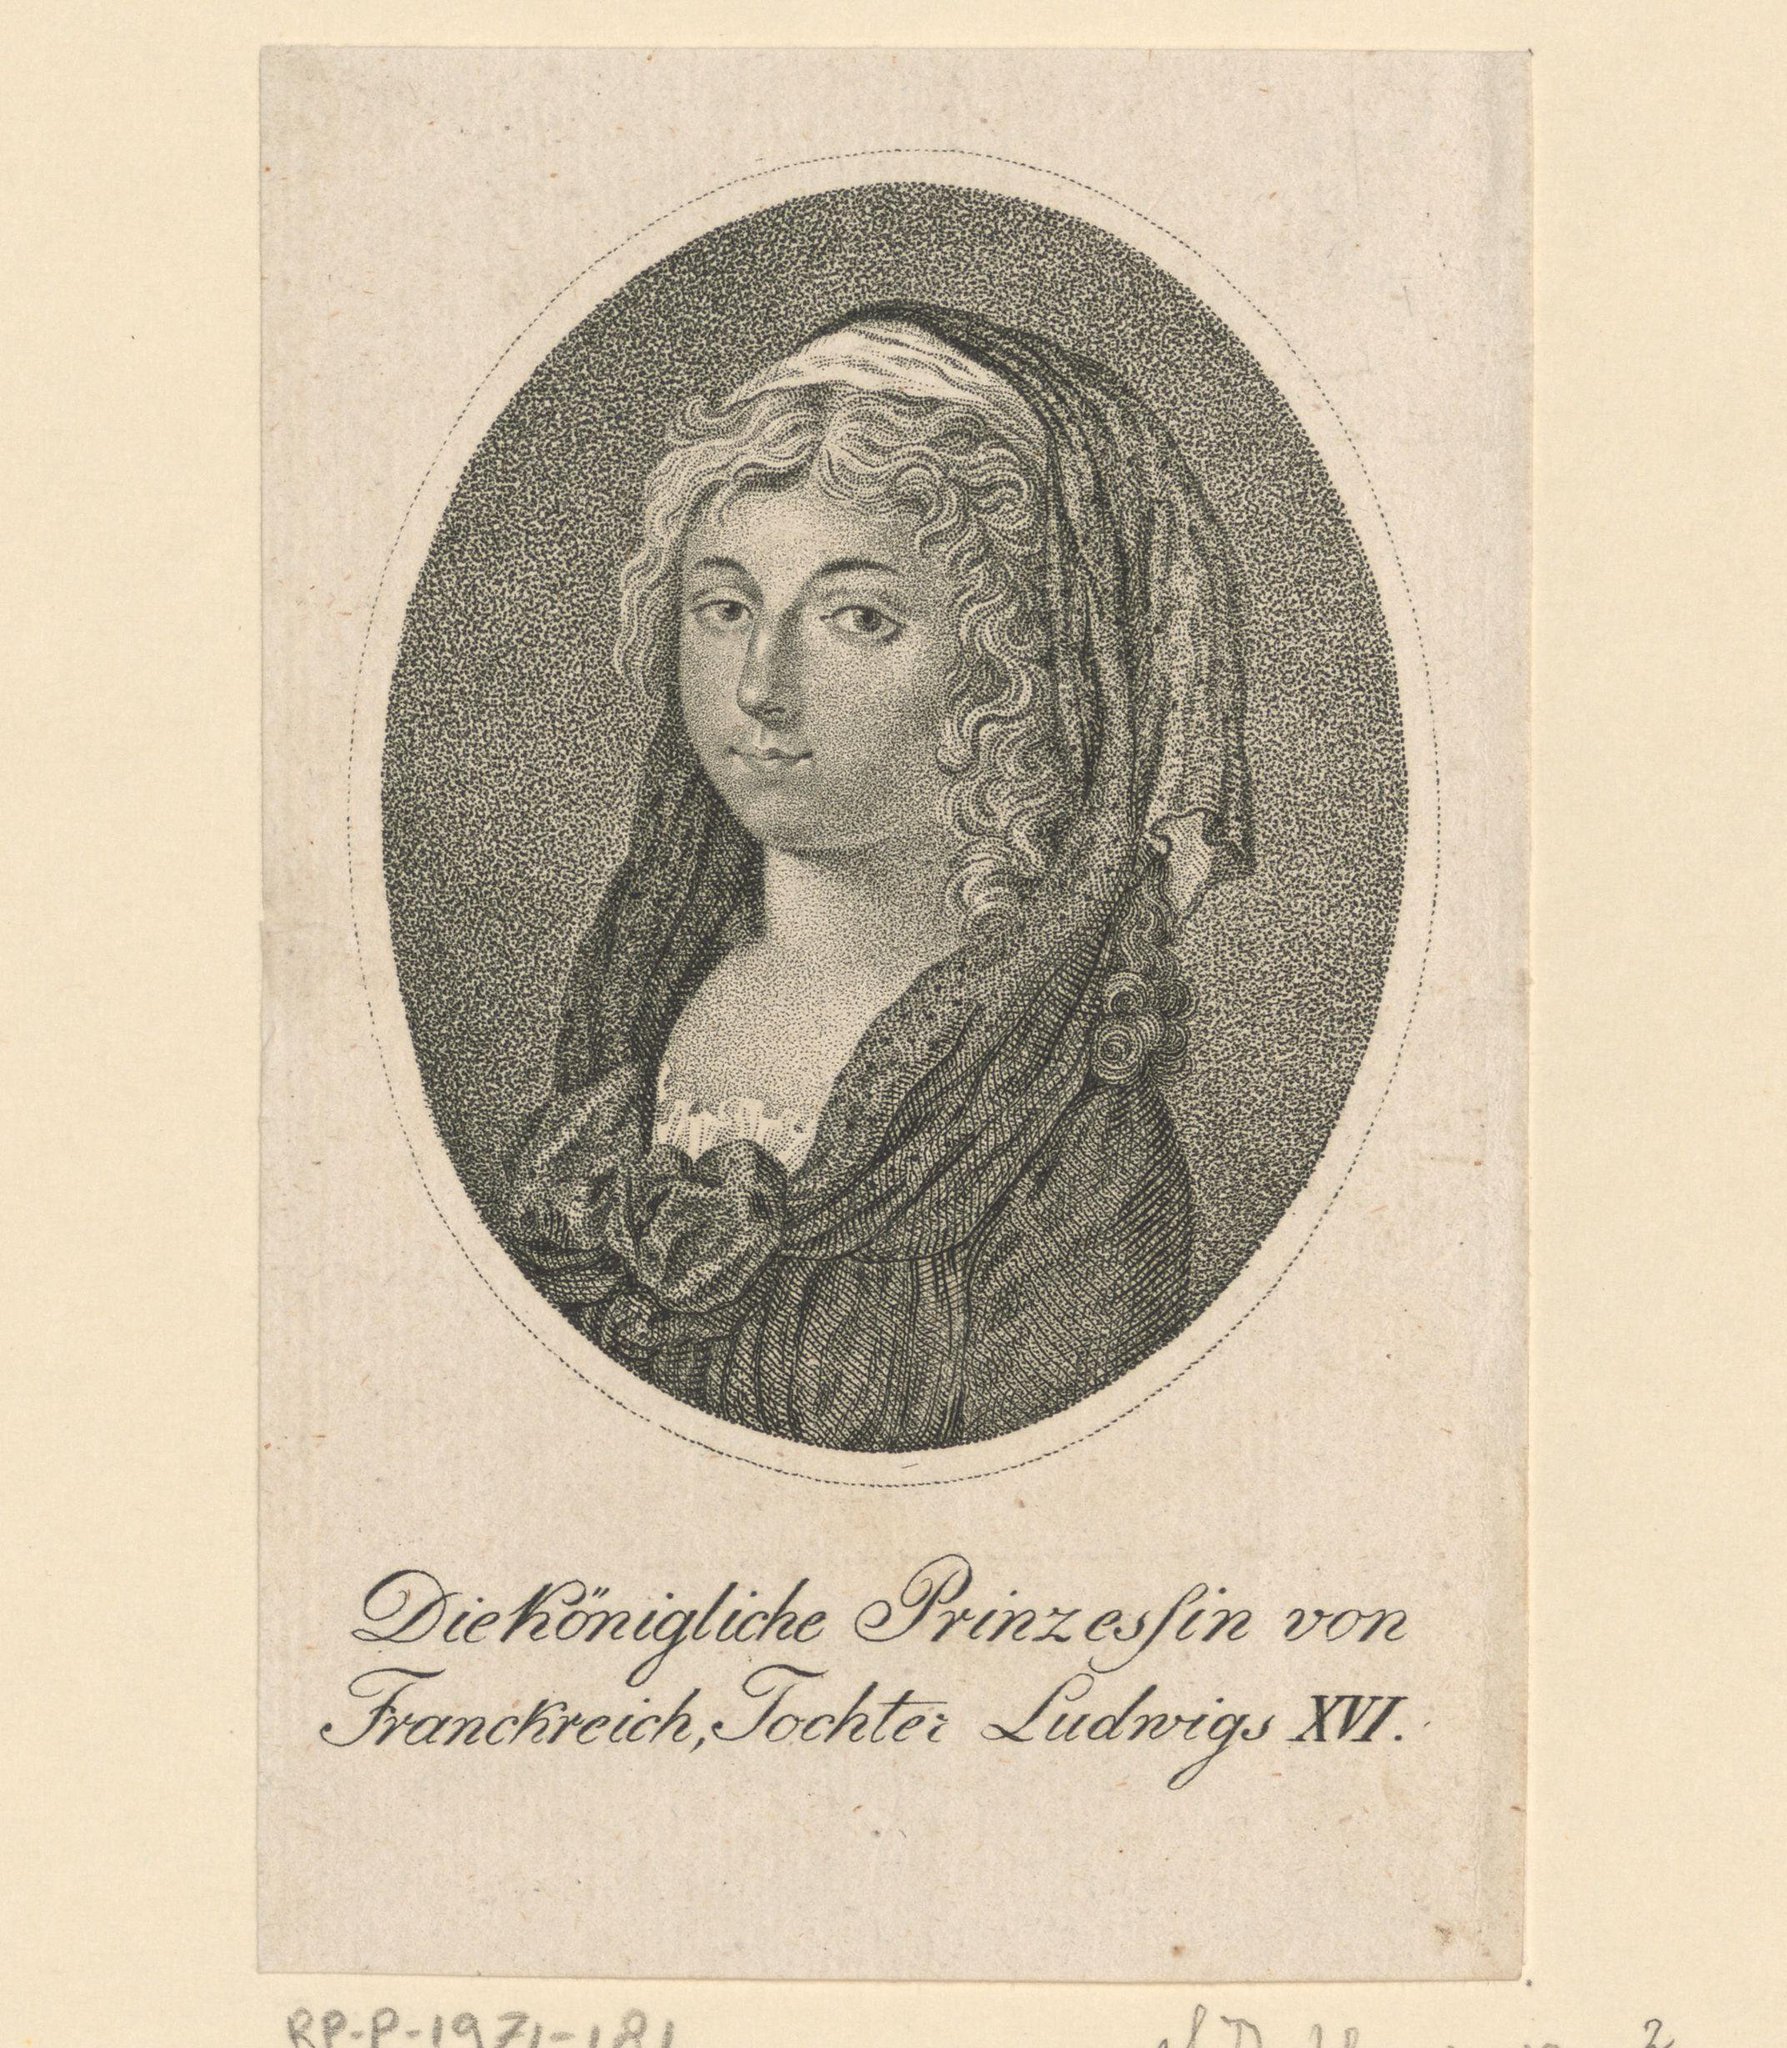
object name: print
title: Portret van Marie Thérèse Charlotte van Frankrijk, hertogin van Angoulême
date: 1797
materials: paper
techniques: etching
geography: gottingen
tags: vienna, marie thérèse charlotte van frankrijk, historical persons - bb - woman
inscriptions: collector's mark: Lugt 2760, collector's mark: Lugt 2228